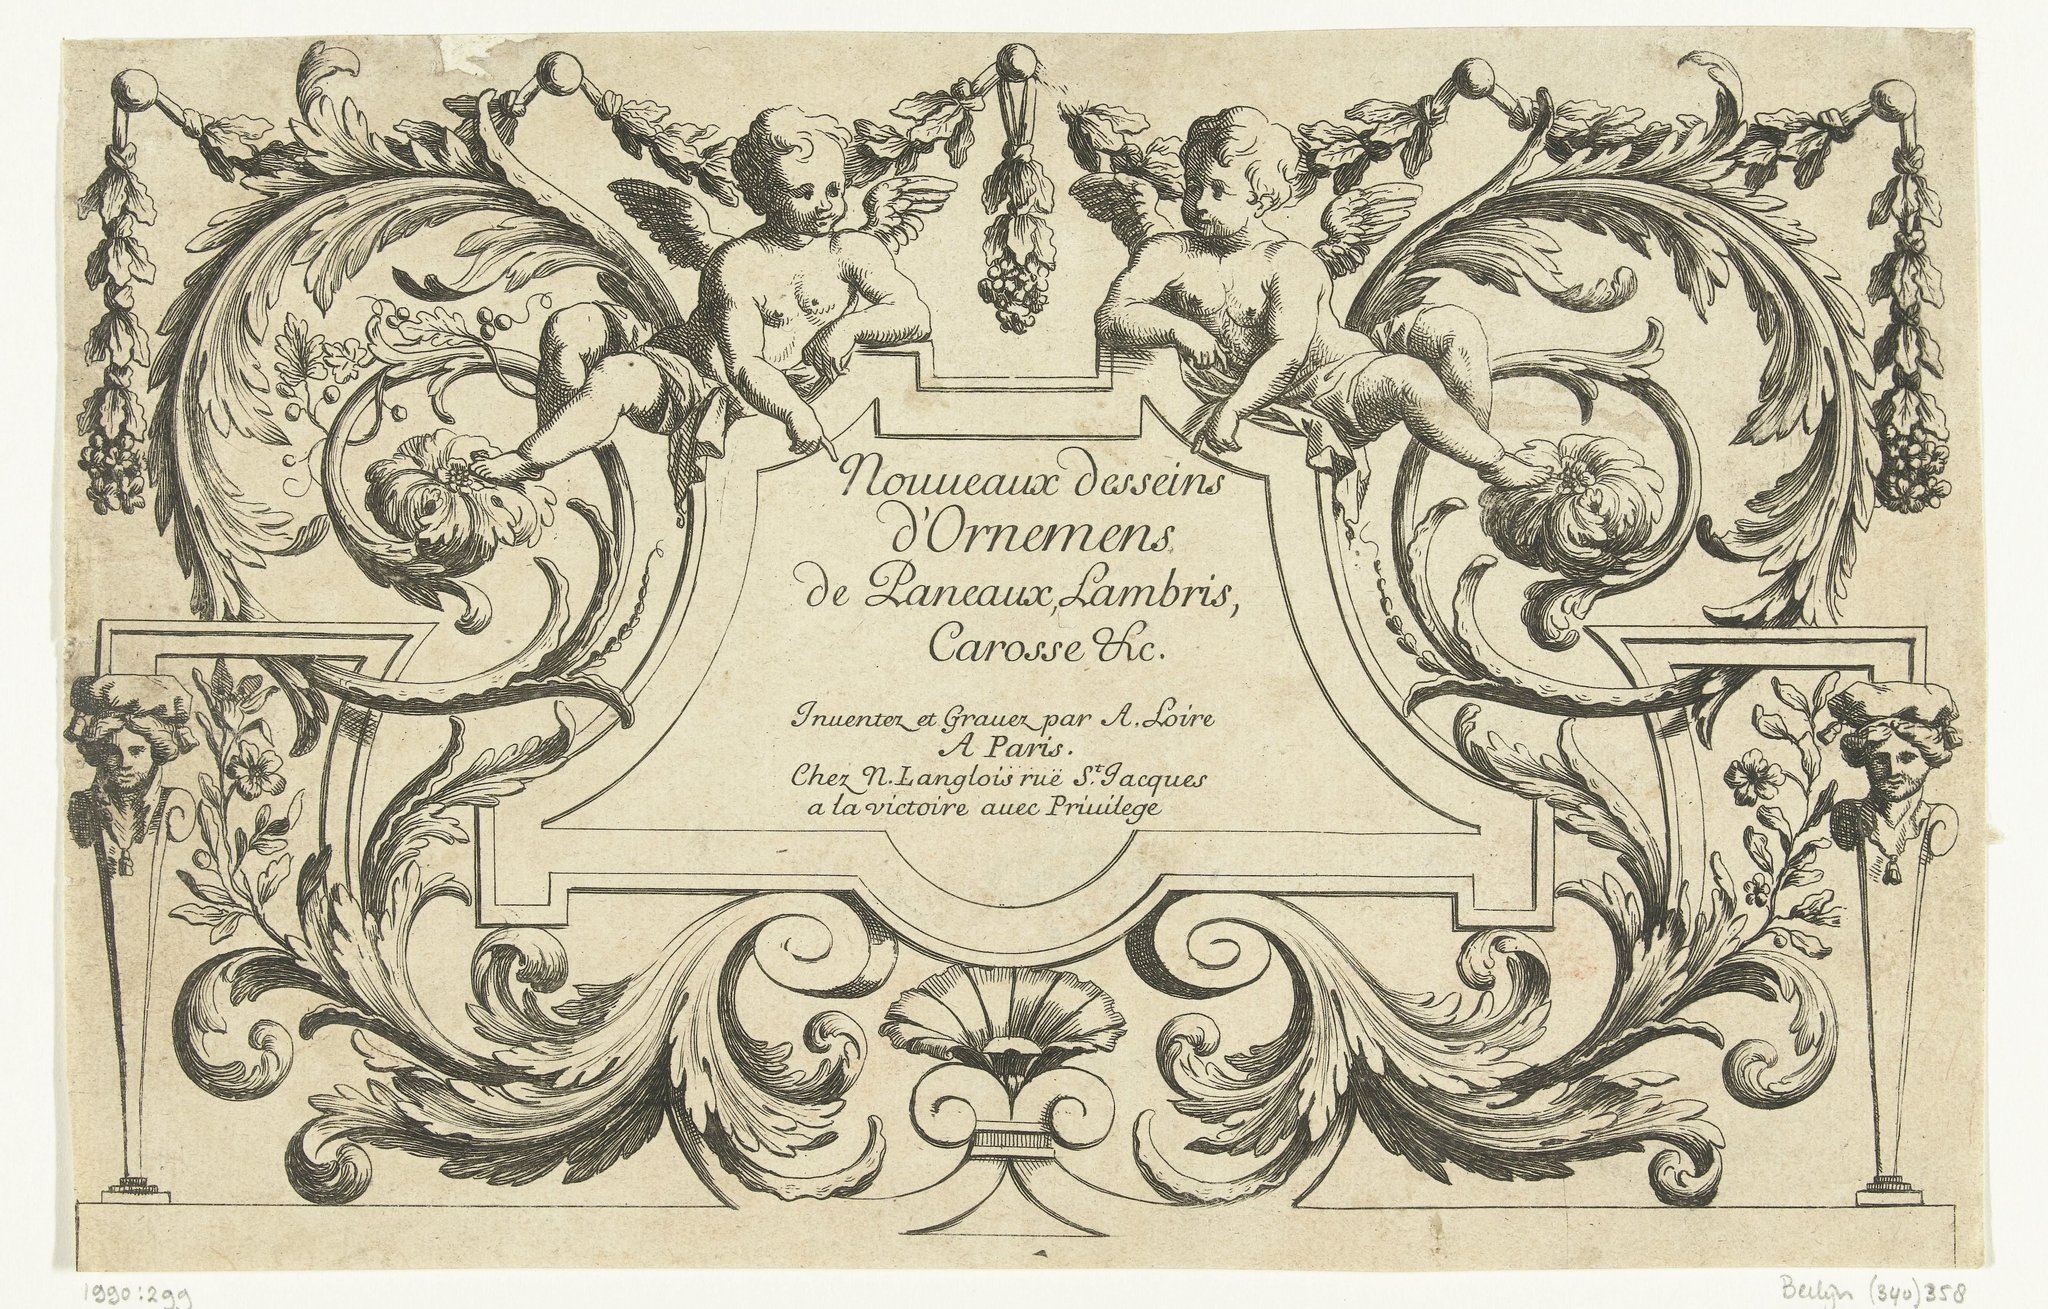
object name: ornament print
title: Titelblad: Nouveaux desseins d'Ornemens de Paneaux, Lambris, Carosse &c.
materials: paper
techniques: engraving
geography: paris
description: De titel staat op een trapeziumvormig paneel in het midden met daarboven twee putti. Titelblad uit tweede editie, derde afdruk.